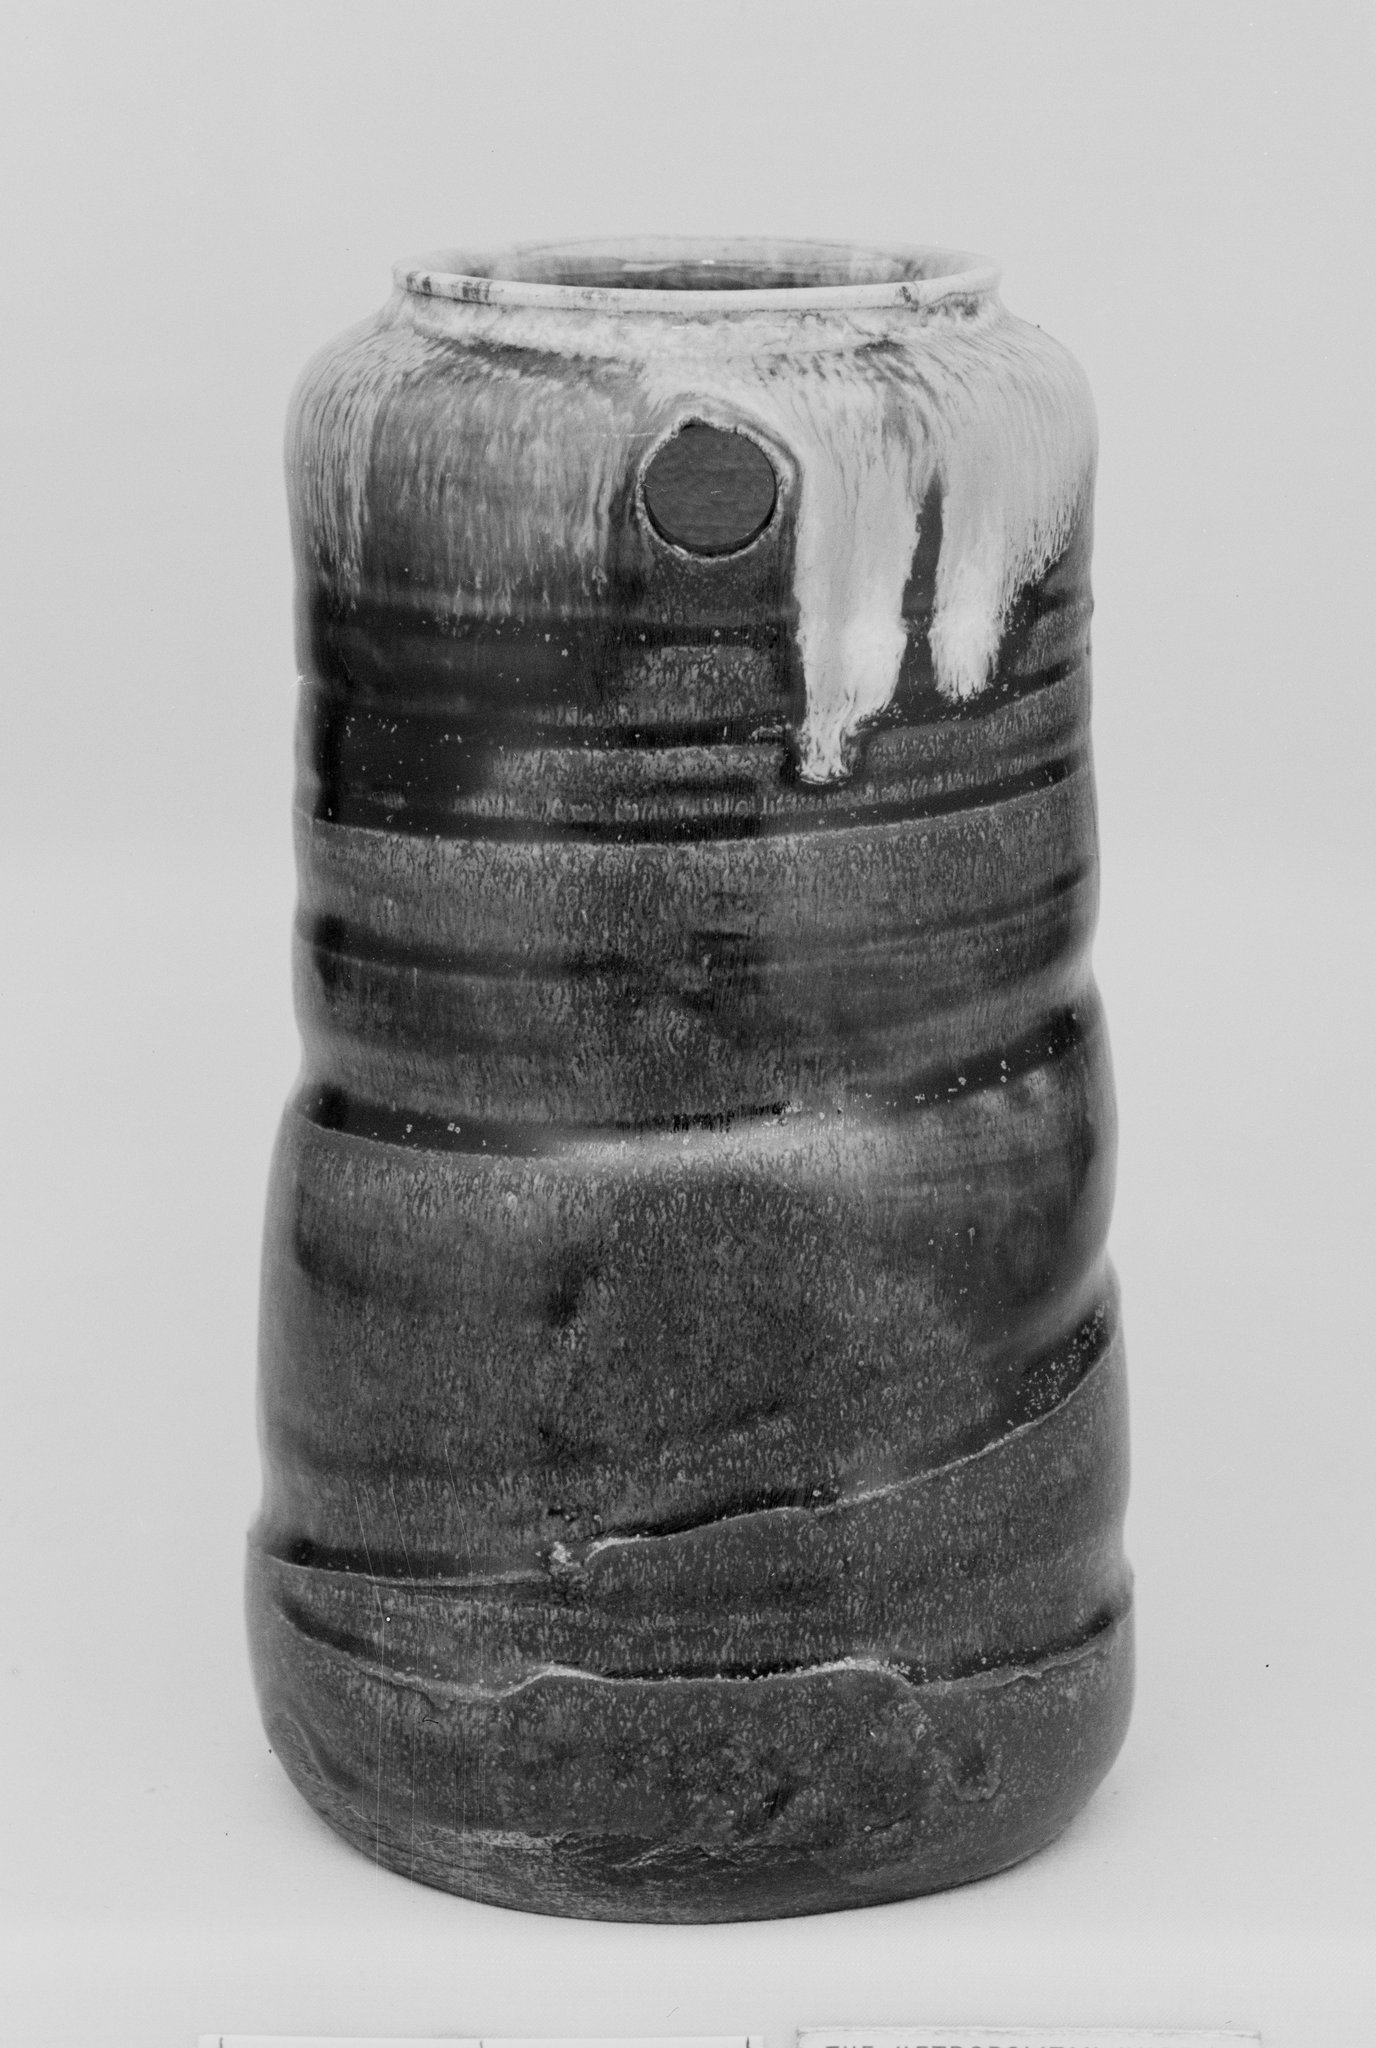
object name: hanging vase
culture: japanese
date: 1801-1900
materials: clay, glaze